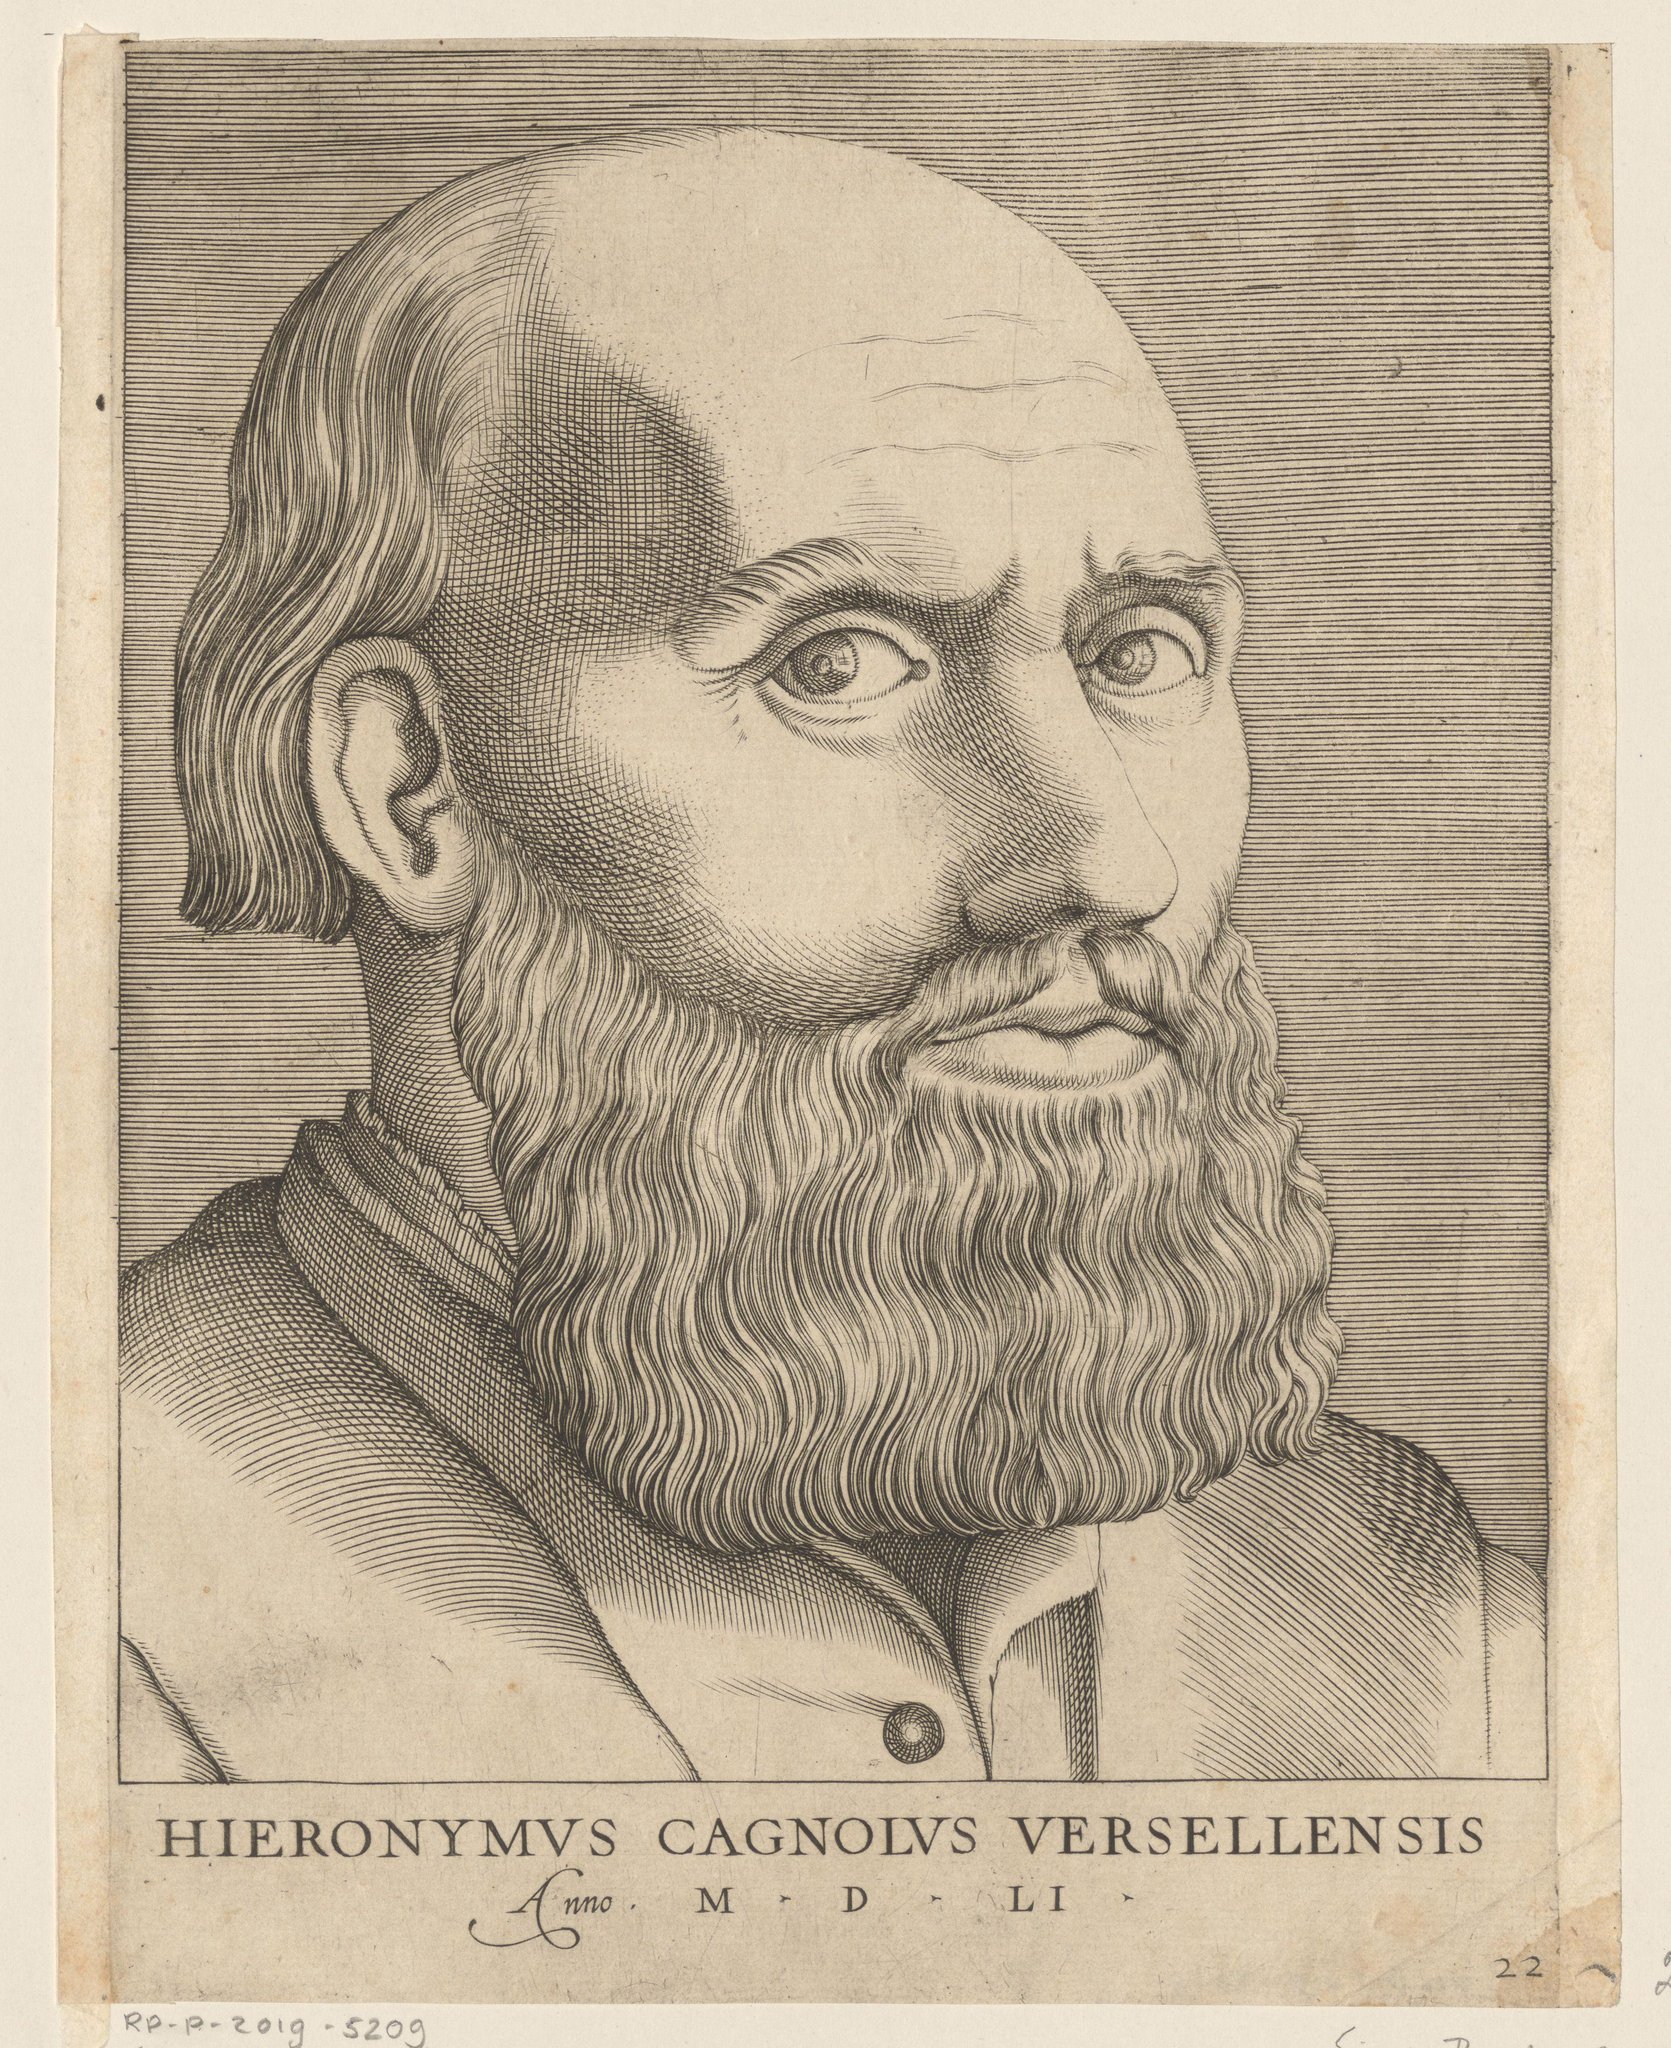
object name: print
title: Portret van Girolamo Cagnoli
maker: Anonymous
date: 1566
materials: paper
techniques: engraving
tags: historical persons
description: Prentserie voor het eerst uitgegeven te Rome door Antonio Lafreri in 1566. Serie waarschijnlijk opnieuw uitgegeven door Petri de' Nobili rond 1584-1585.